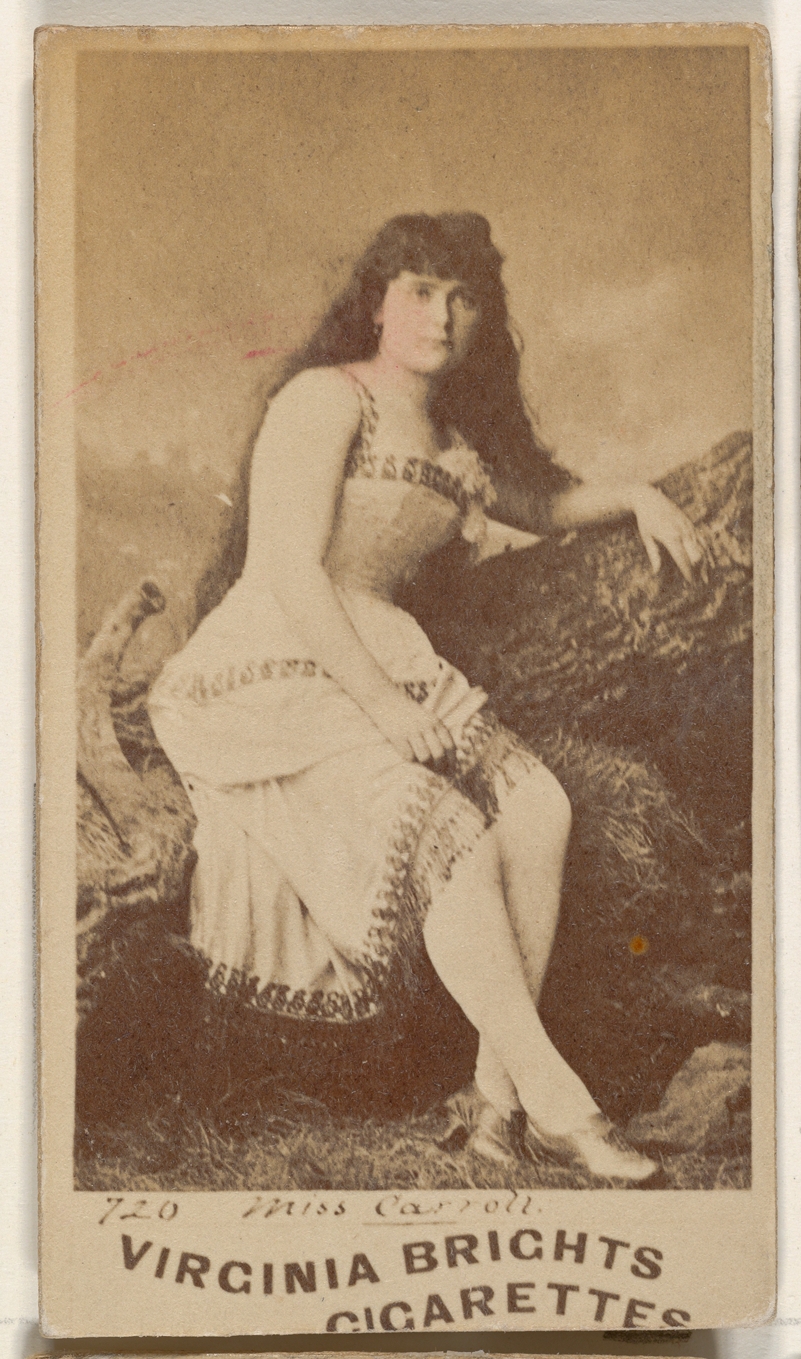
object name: photograph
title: Card 720, Miss Carroll, from the Actors and Actresses series (N45, Type 1) for Virginia Brights Cigarettes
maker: allen & ginter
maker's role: publisher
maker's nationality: american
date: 1888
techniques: albumen silver print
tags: portraits,women,actresses